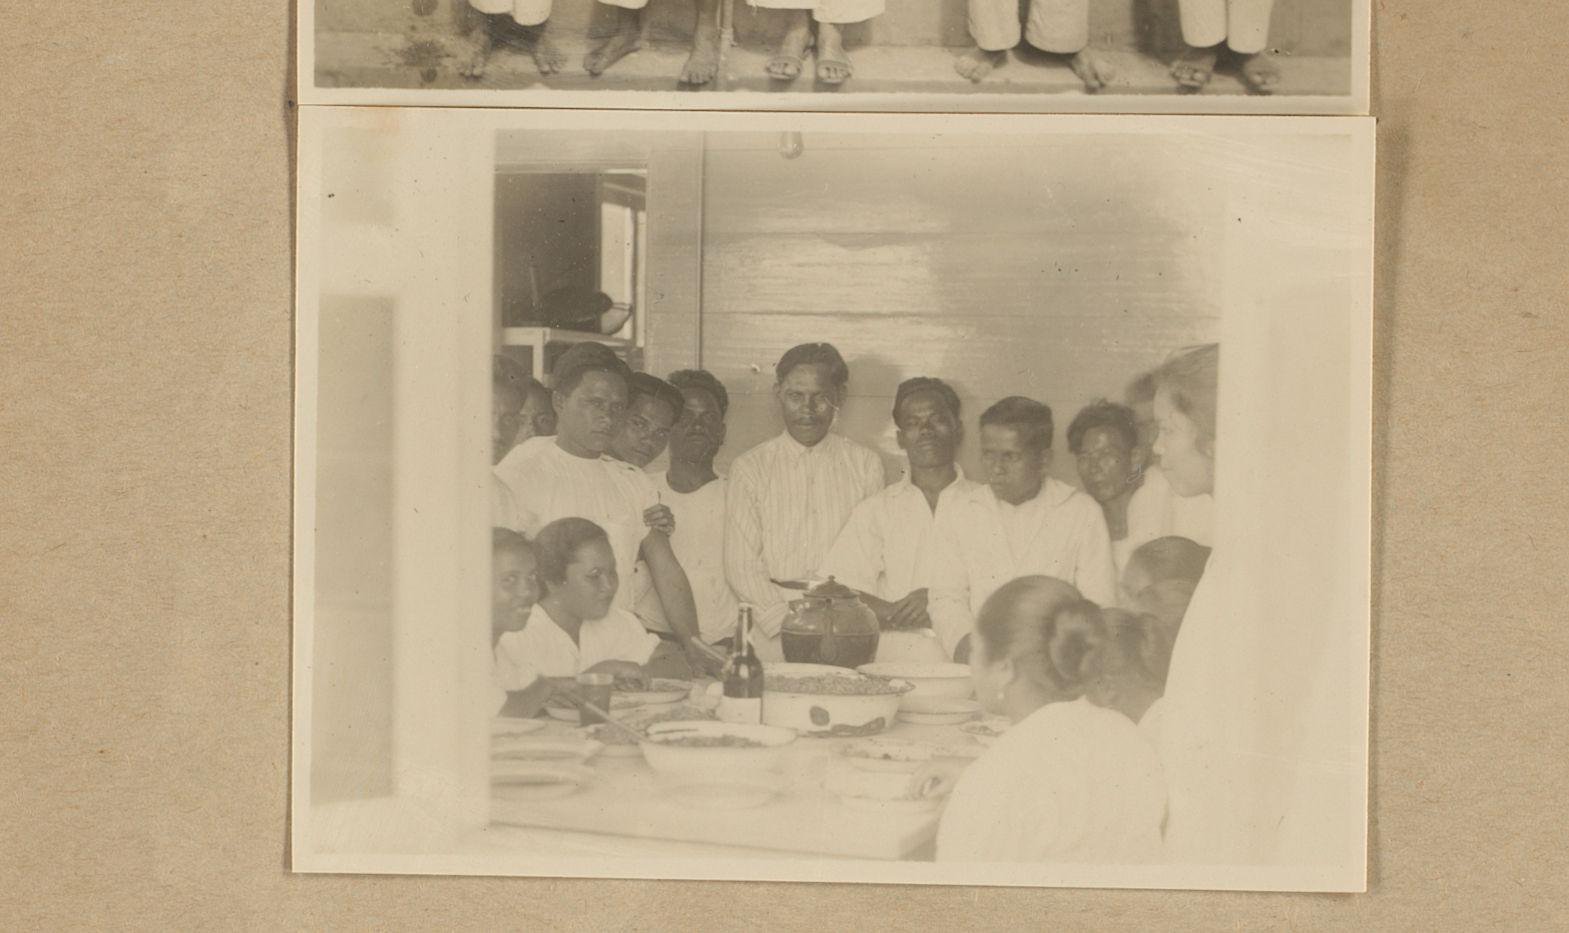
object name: photograph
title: Inwijding met "makanen besar" van verbouwde keuken en eetkamer van het personeel. Op de voorgrond rechts de twee timmerlui, links de drie kokkies.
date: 1929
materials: cardboard, photographic support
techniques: gelatin silver print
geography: kabanjahe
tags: colonial system, hospital, anonymous historical persons portrayed in a group, in a group-portrait, sumatra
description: Foto (b) van het feestmaal (makanen besar) bij de inwijding van de verbouwde keuken en eetkamer van het personeel van het hospitaal. Datum van foto: 17 november 1929. Foto geplakt op voorgedrukt kartonnen blad ingebonden in het fotoalbum over het Hospitaal Batak Instituut te Kabanjaheh op Sumatra in de jaren 1926-1929.